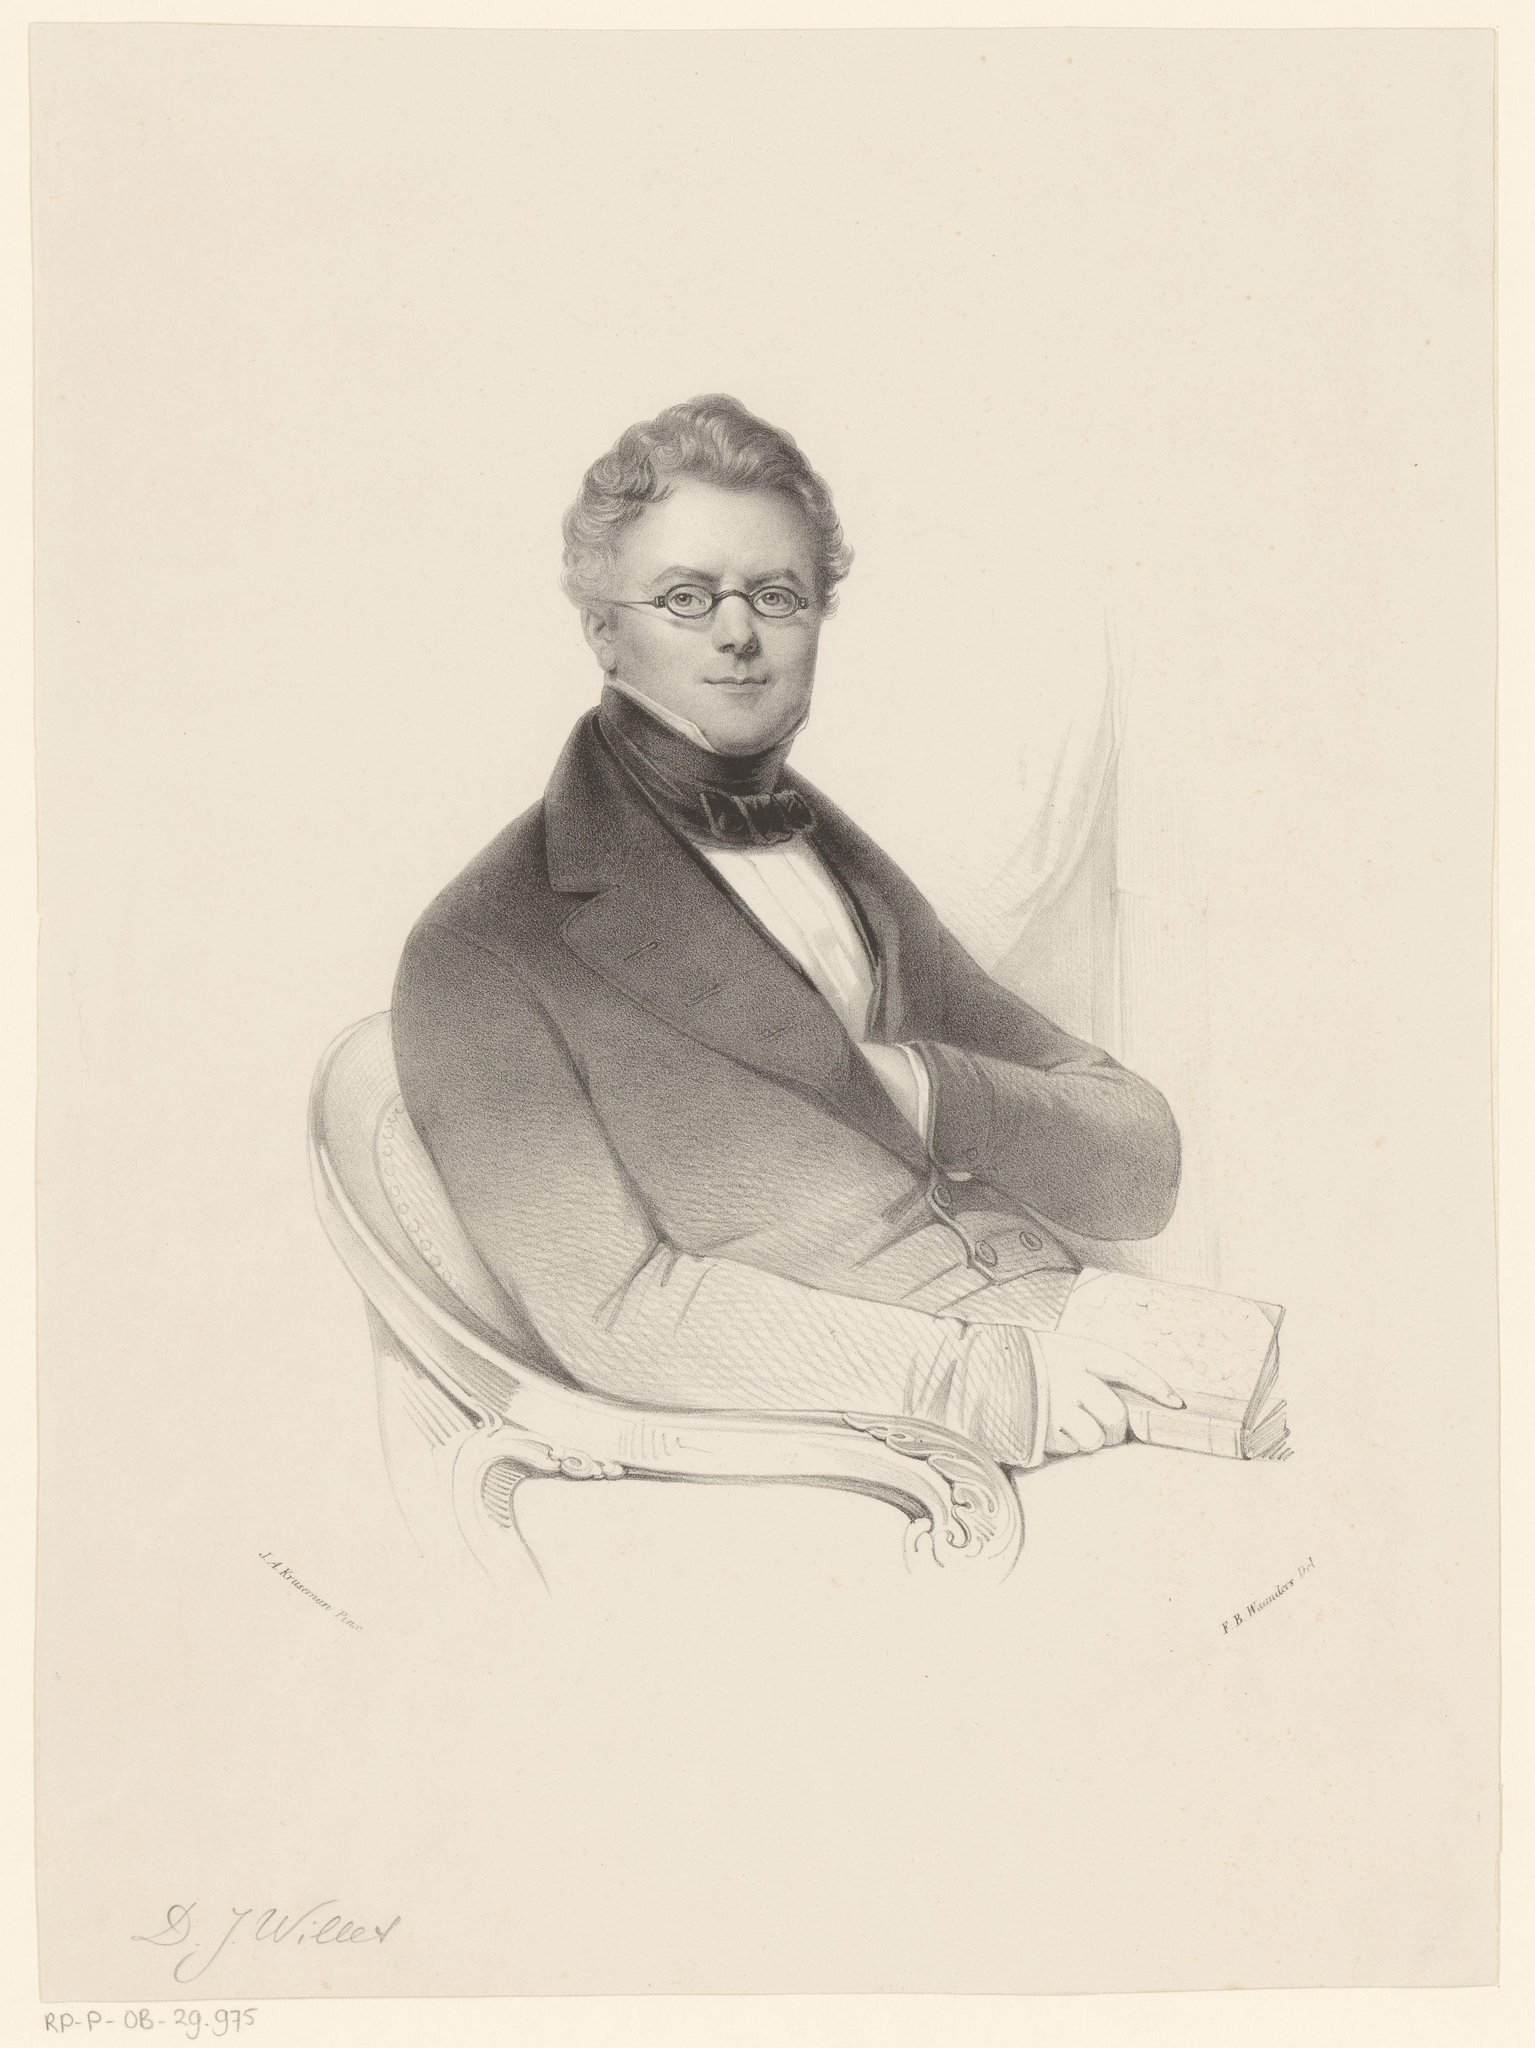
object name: print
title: Portret van Abraham Willet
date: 1833-1880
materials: paper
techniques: lithograph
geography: netherlands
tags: historical persons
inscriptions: collector's mark: Lugt 2228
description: Naar Portret van Abraham Willet (1833) van Jan Adam Kruseman in de collectie van het Amsterdam Museum te Amsterdam.